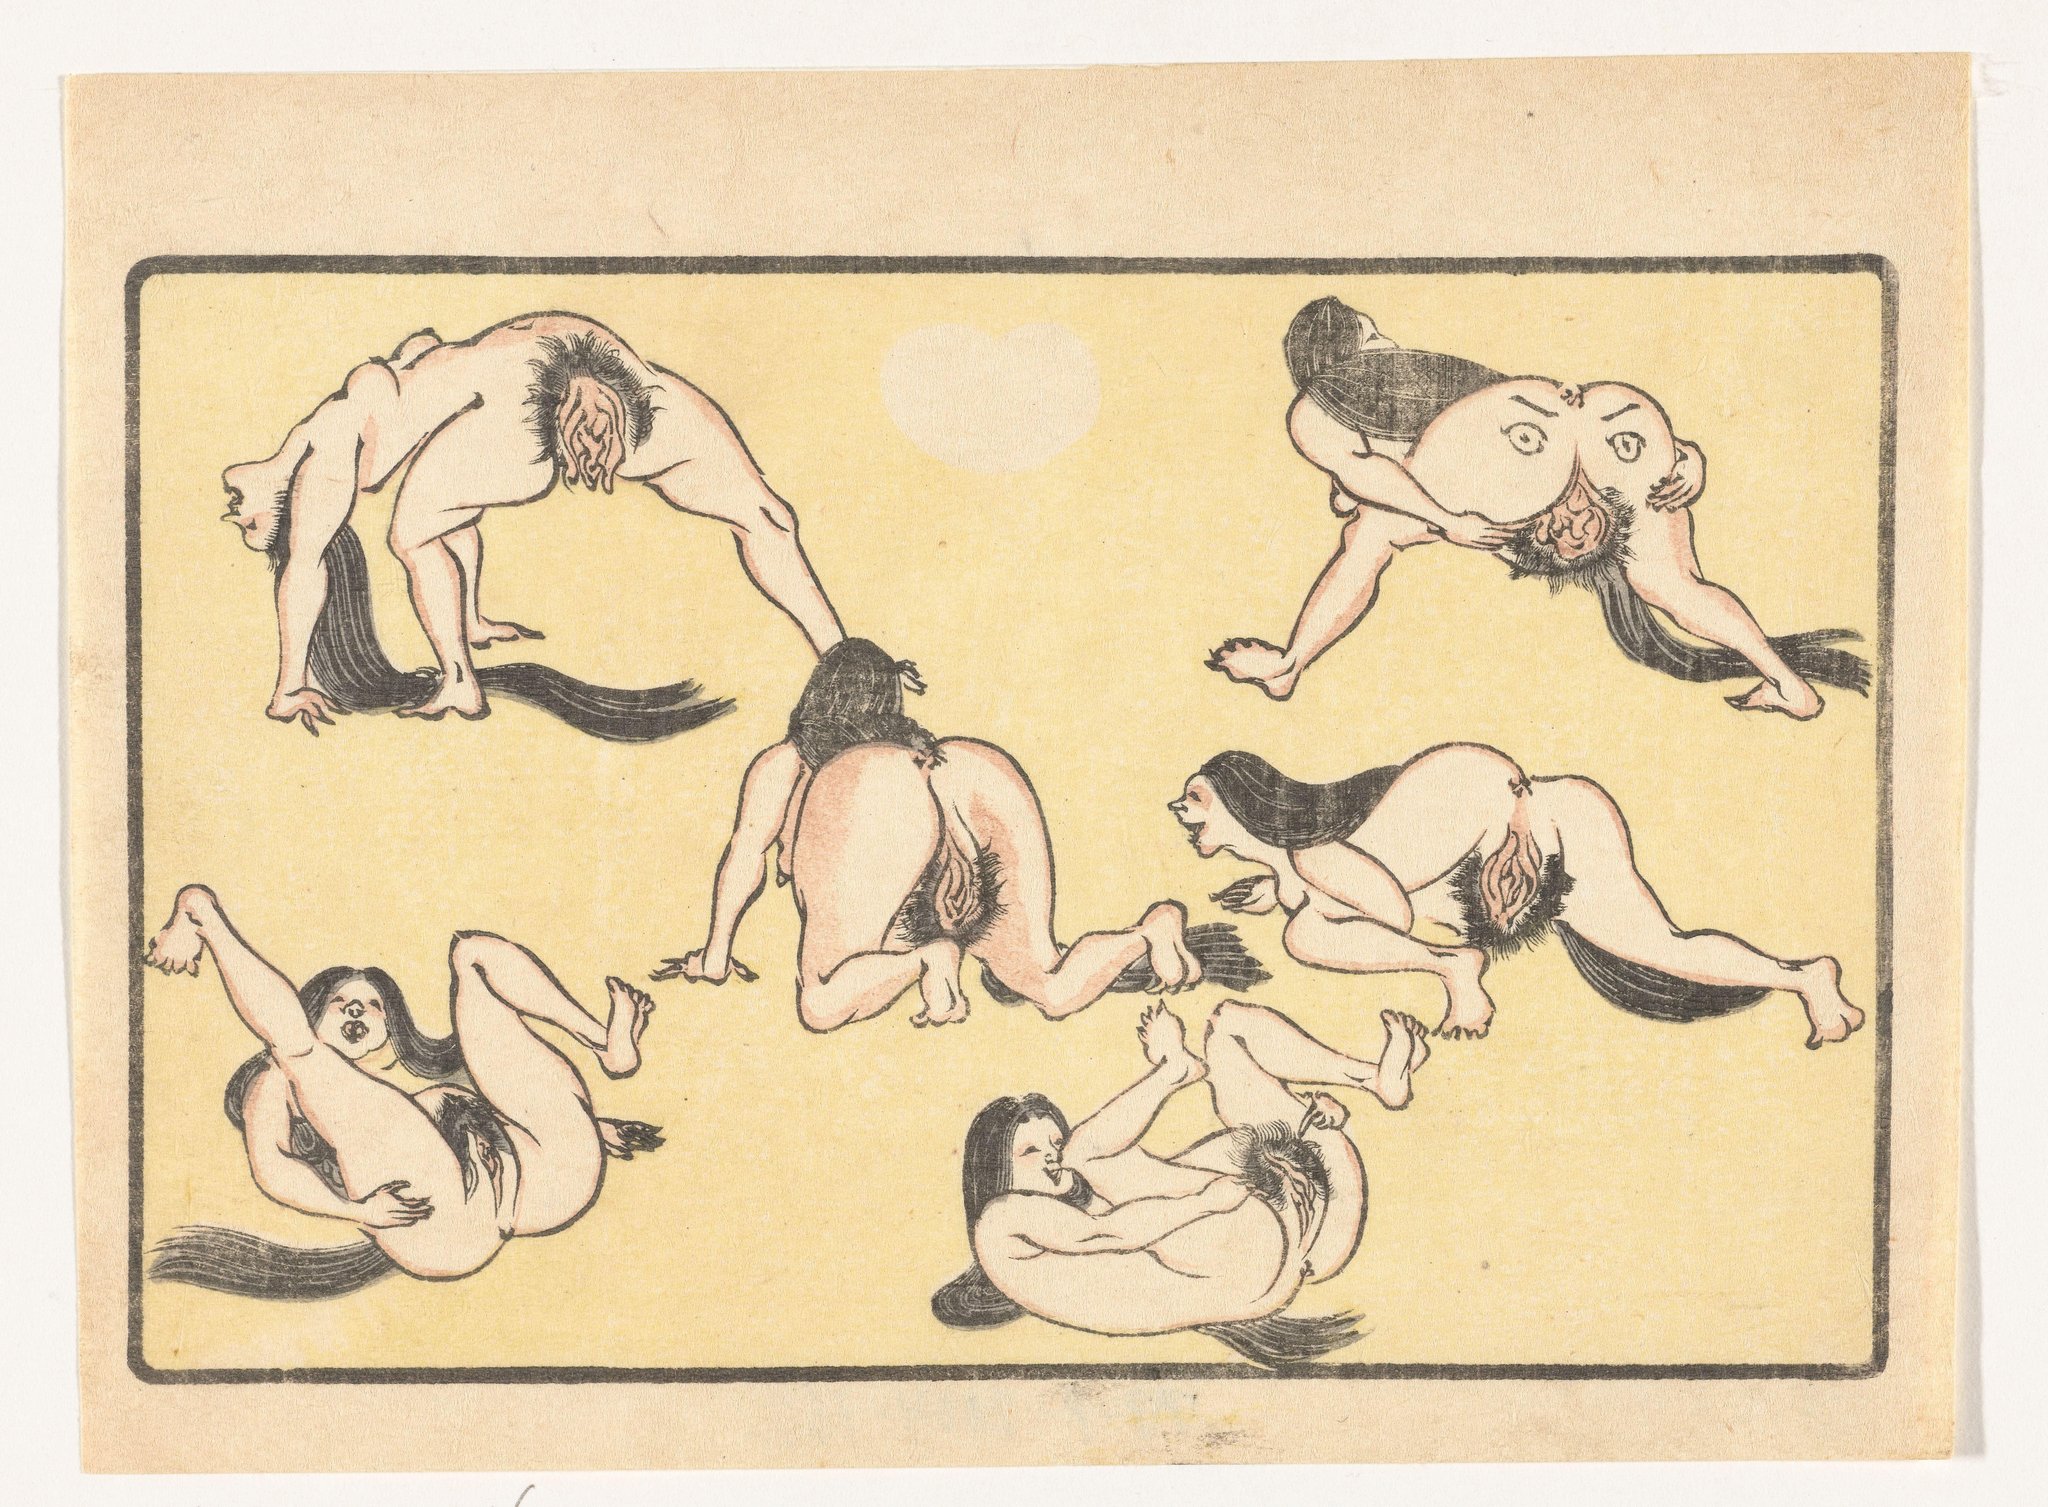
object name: shunga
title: Naakte vrouwen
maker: kawanabe kyôsai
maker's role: draughtsman, print maker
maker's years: 1831-1889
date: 1870-1880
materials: paper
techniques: woodcut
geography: japan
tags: vagina, woman (showing herself) undressed, quasi-nude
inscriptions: collector's mark: Lugt 2760, collector's mark: Lugt 2228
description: Humoristisch erotische prent; vijf naakte vrouwen met opengesperde vagina`s.